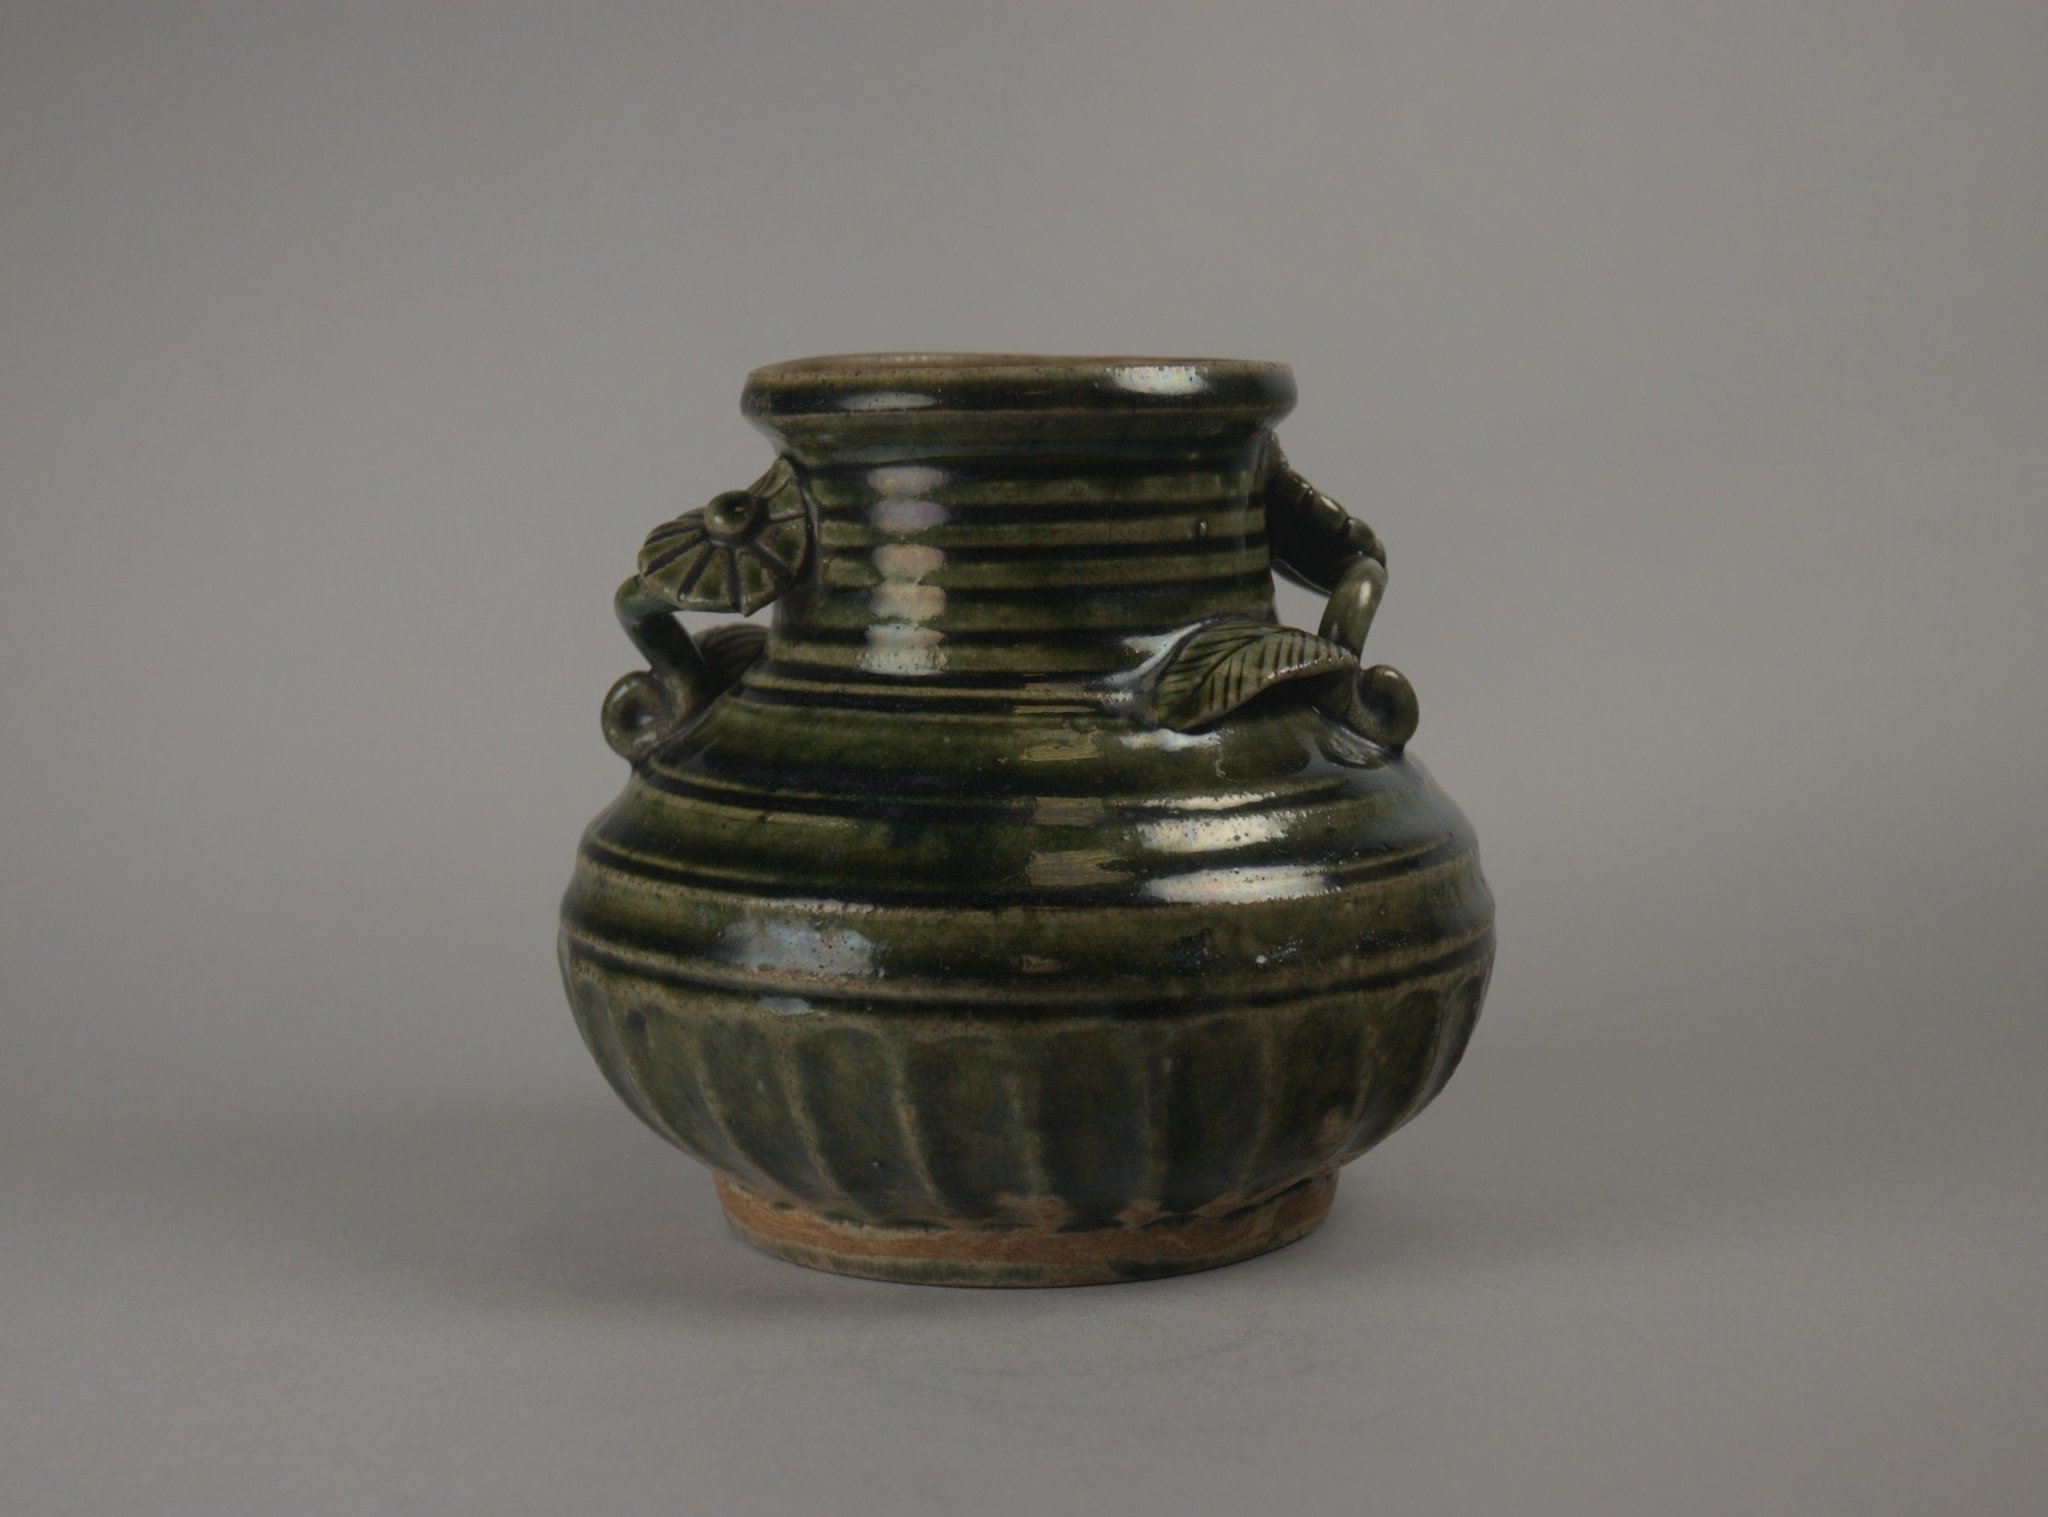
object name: water jar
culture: japanese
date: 1610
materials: copper, glaze, stoneware